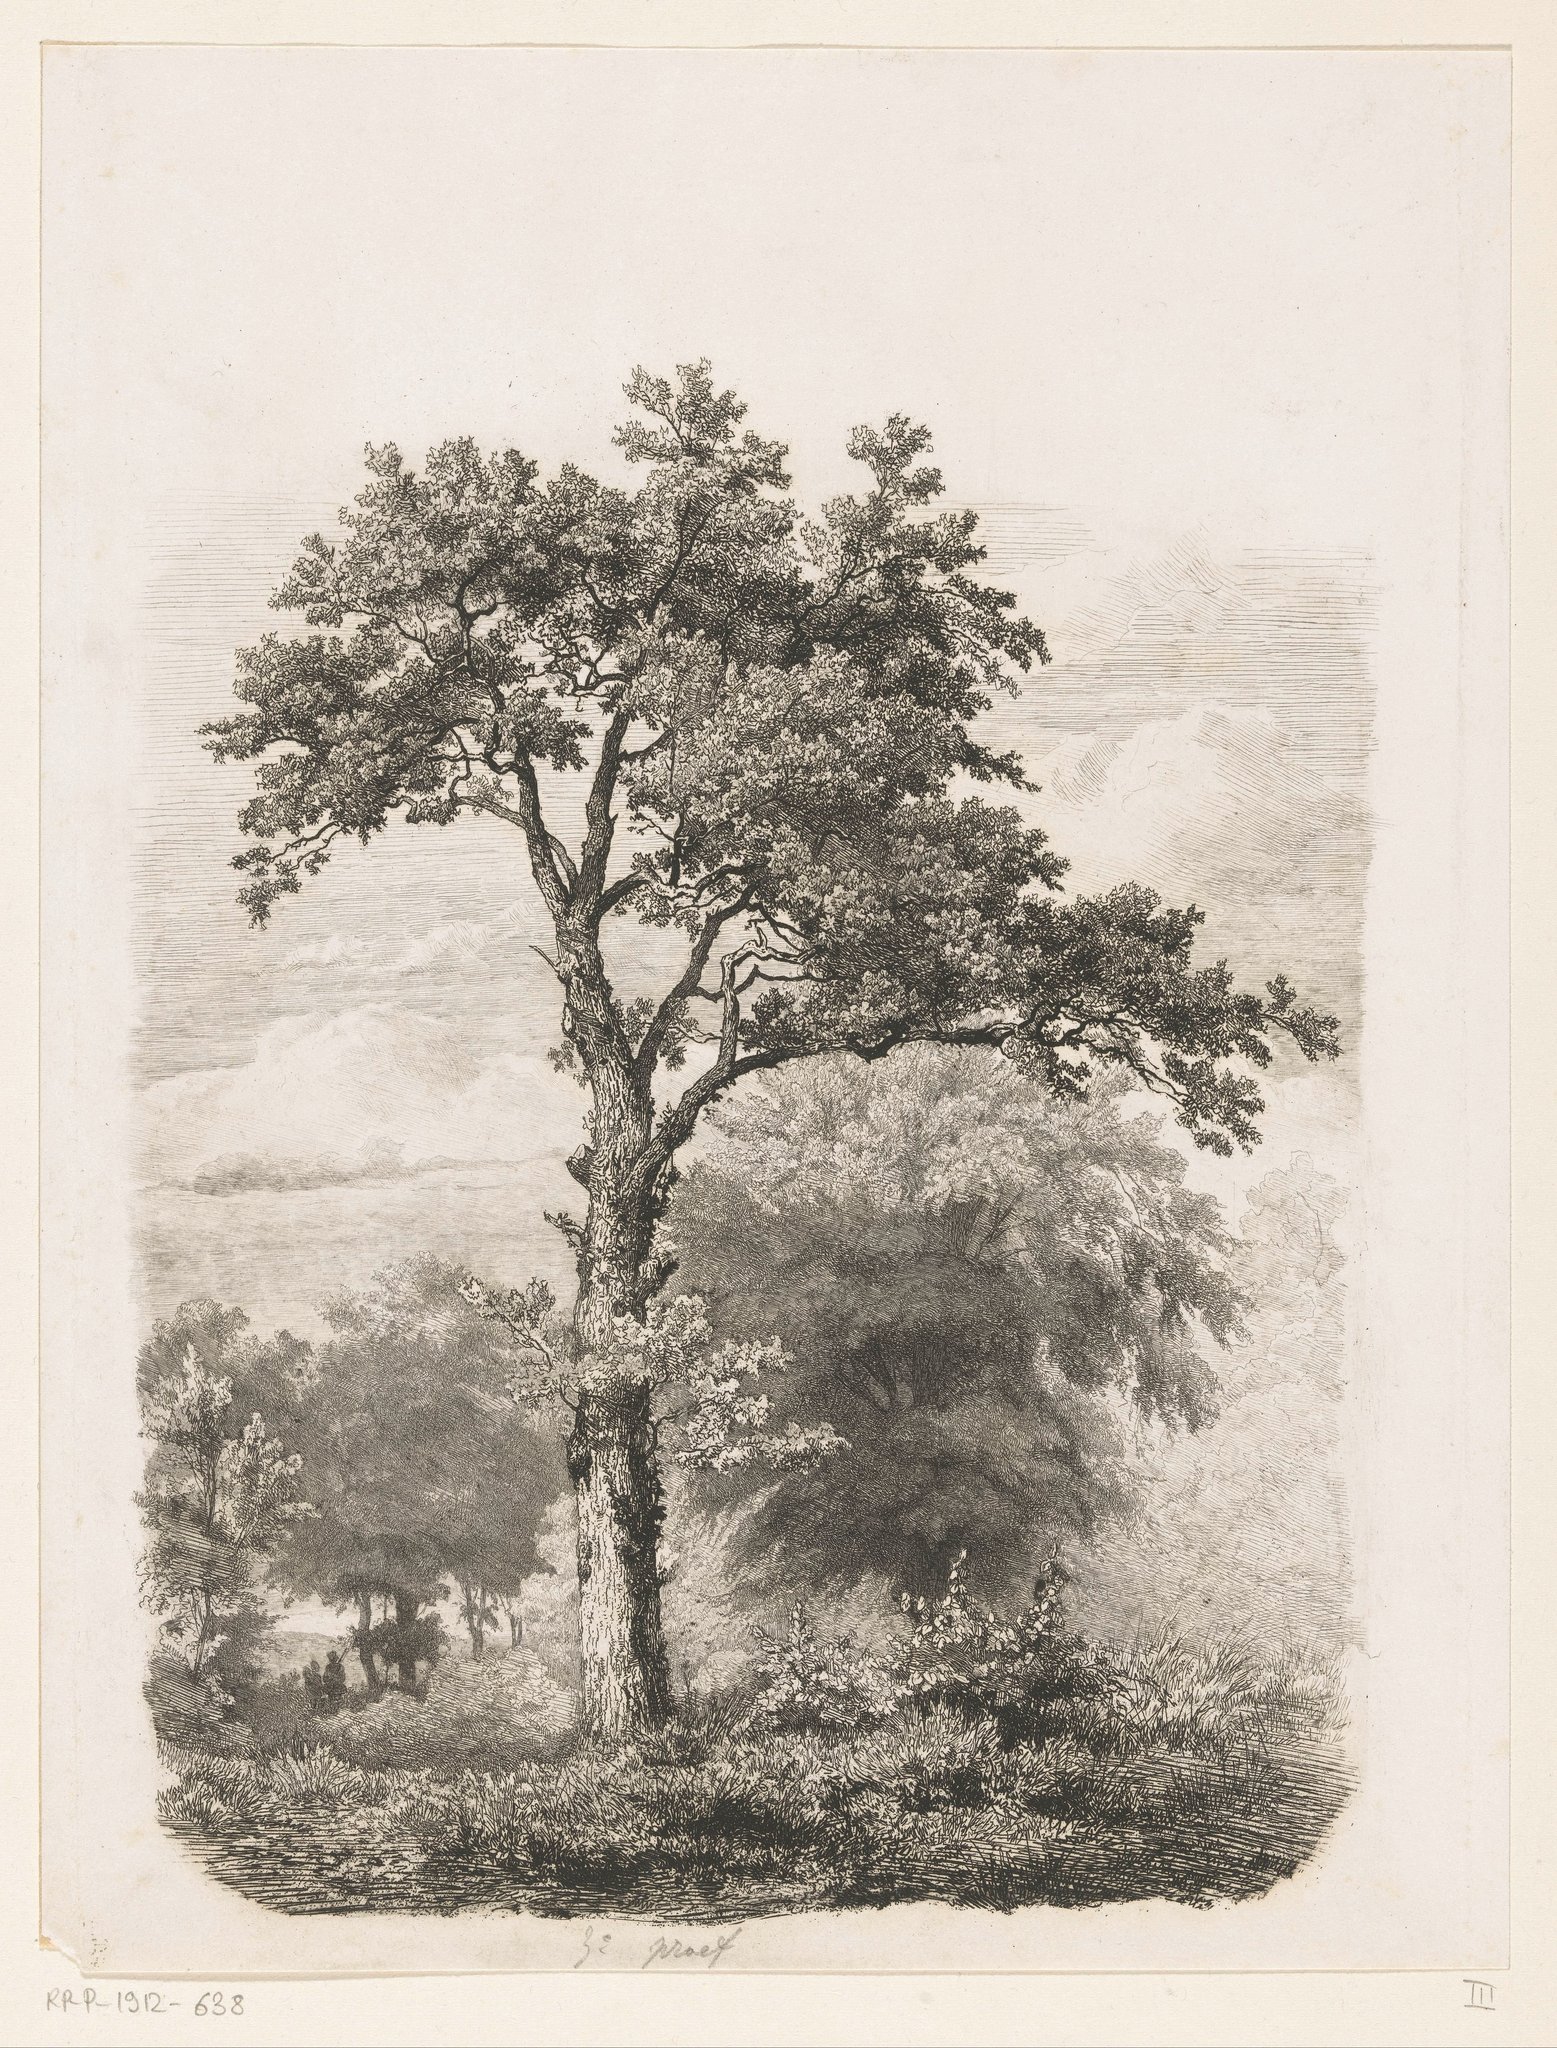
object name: print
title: Vrijstaande loofboom in landschap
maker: pierre louis dubourcq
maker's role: draughtsman, painter, print maker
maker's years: 1815-1873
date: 1840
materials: paper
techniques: drypoint, etching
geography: netherlands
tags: trees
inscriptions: collector's mark: Lugt 2228